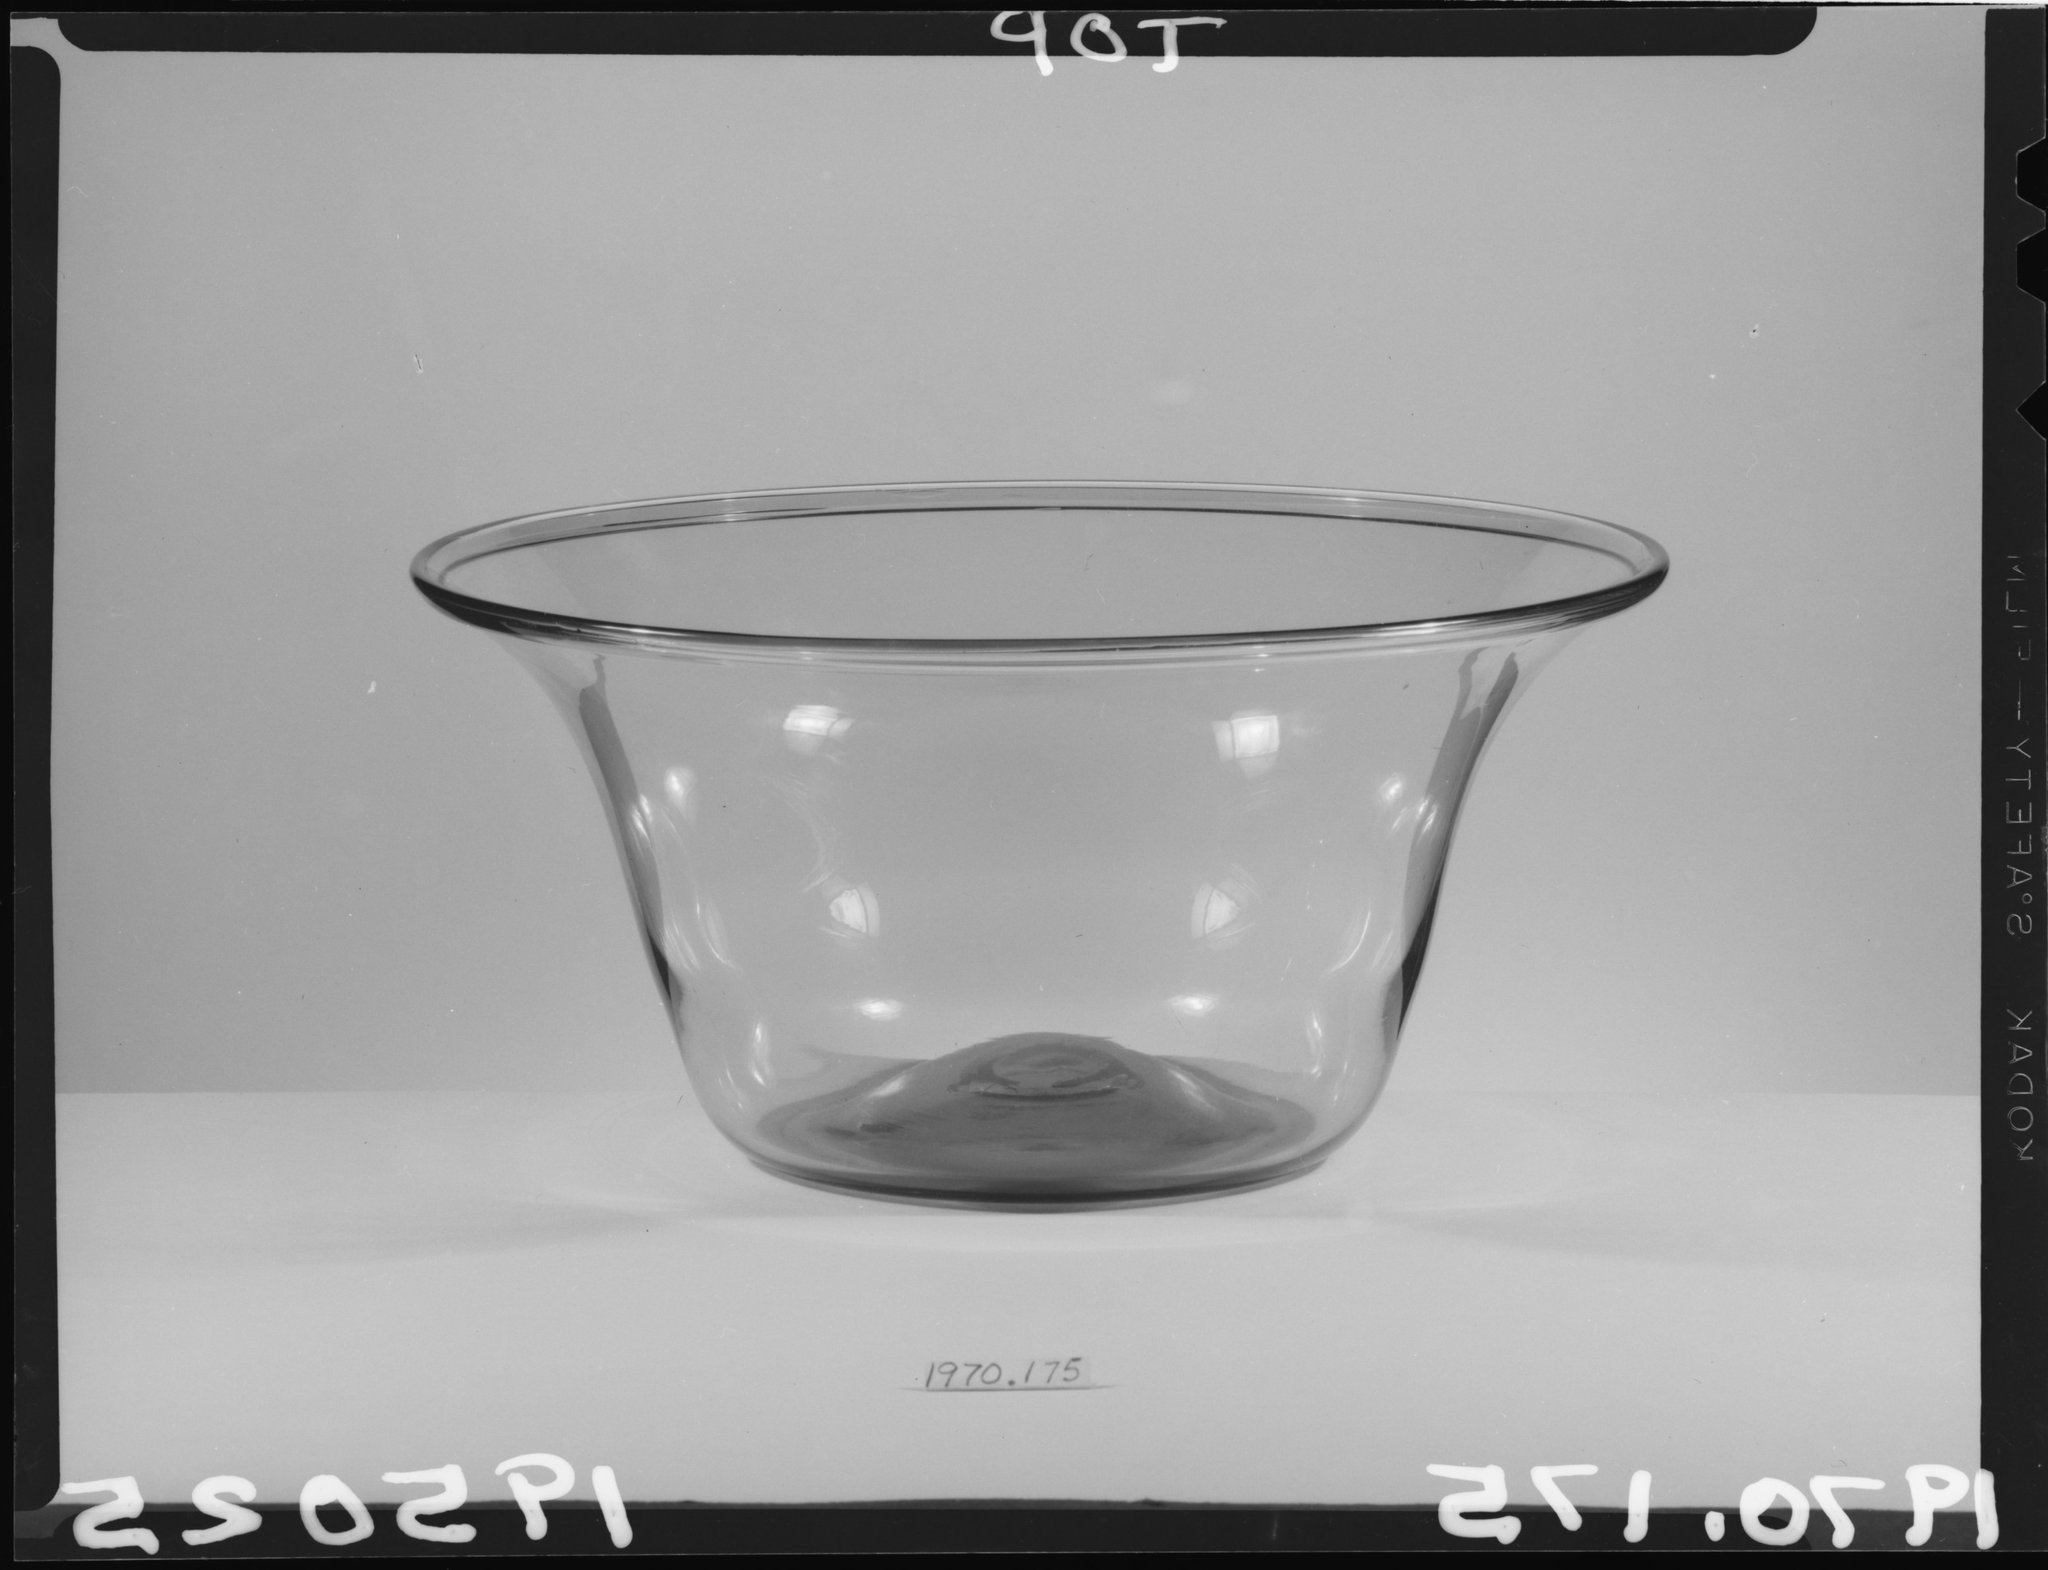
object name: milk bowl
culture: american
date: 1840-1860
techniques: glassblowing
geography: united states